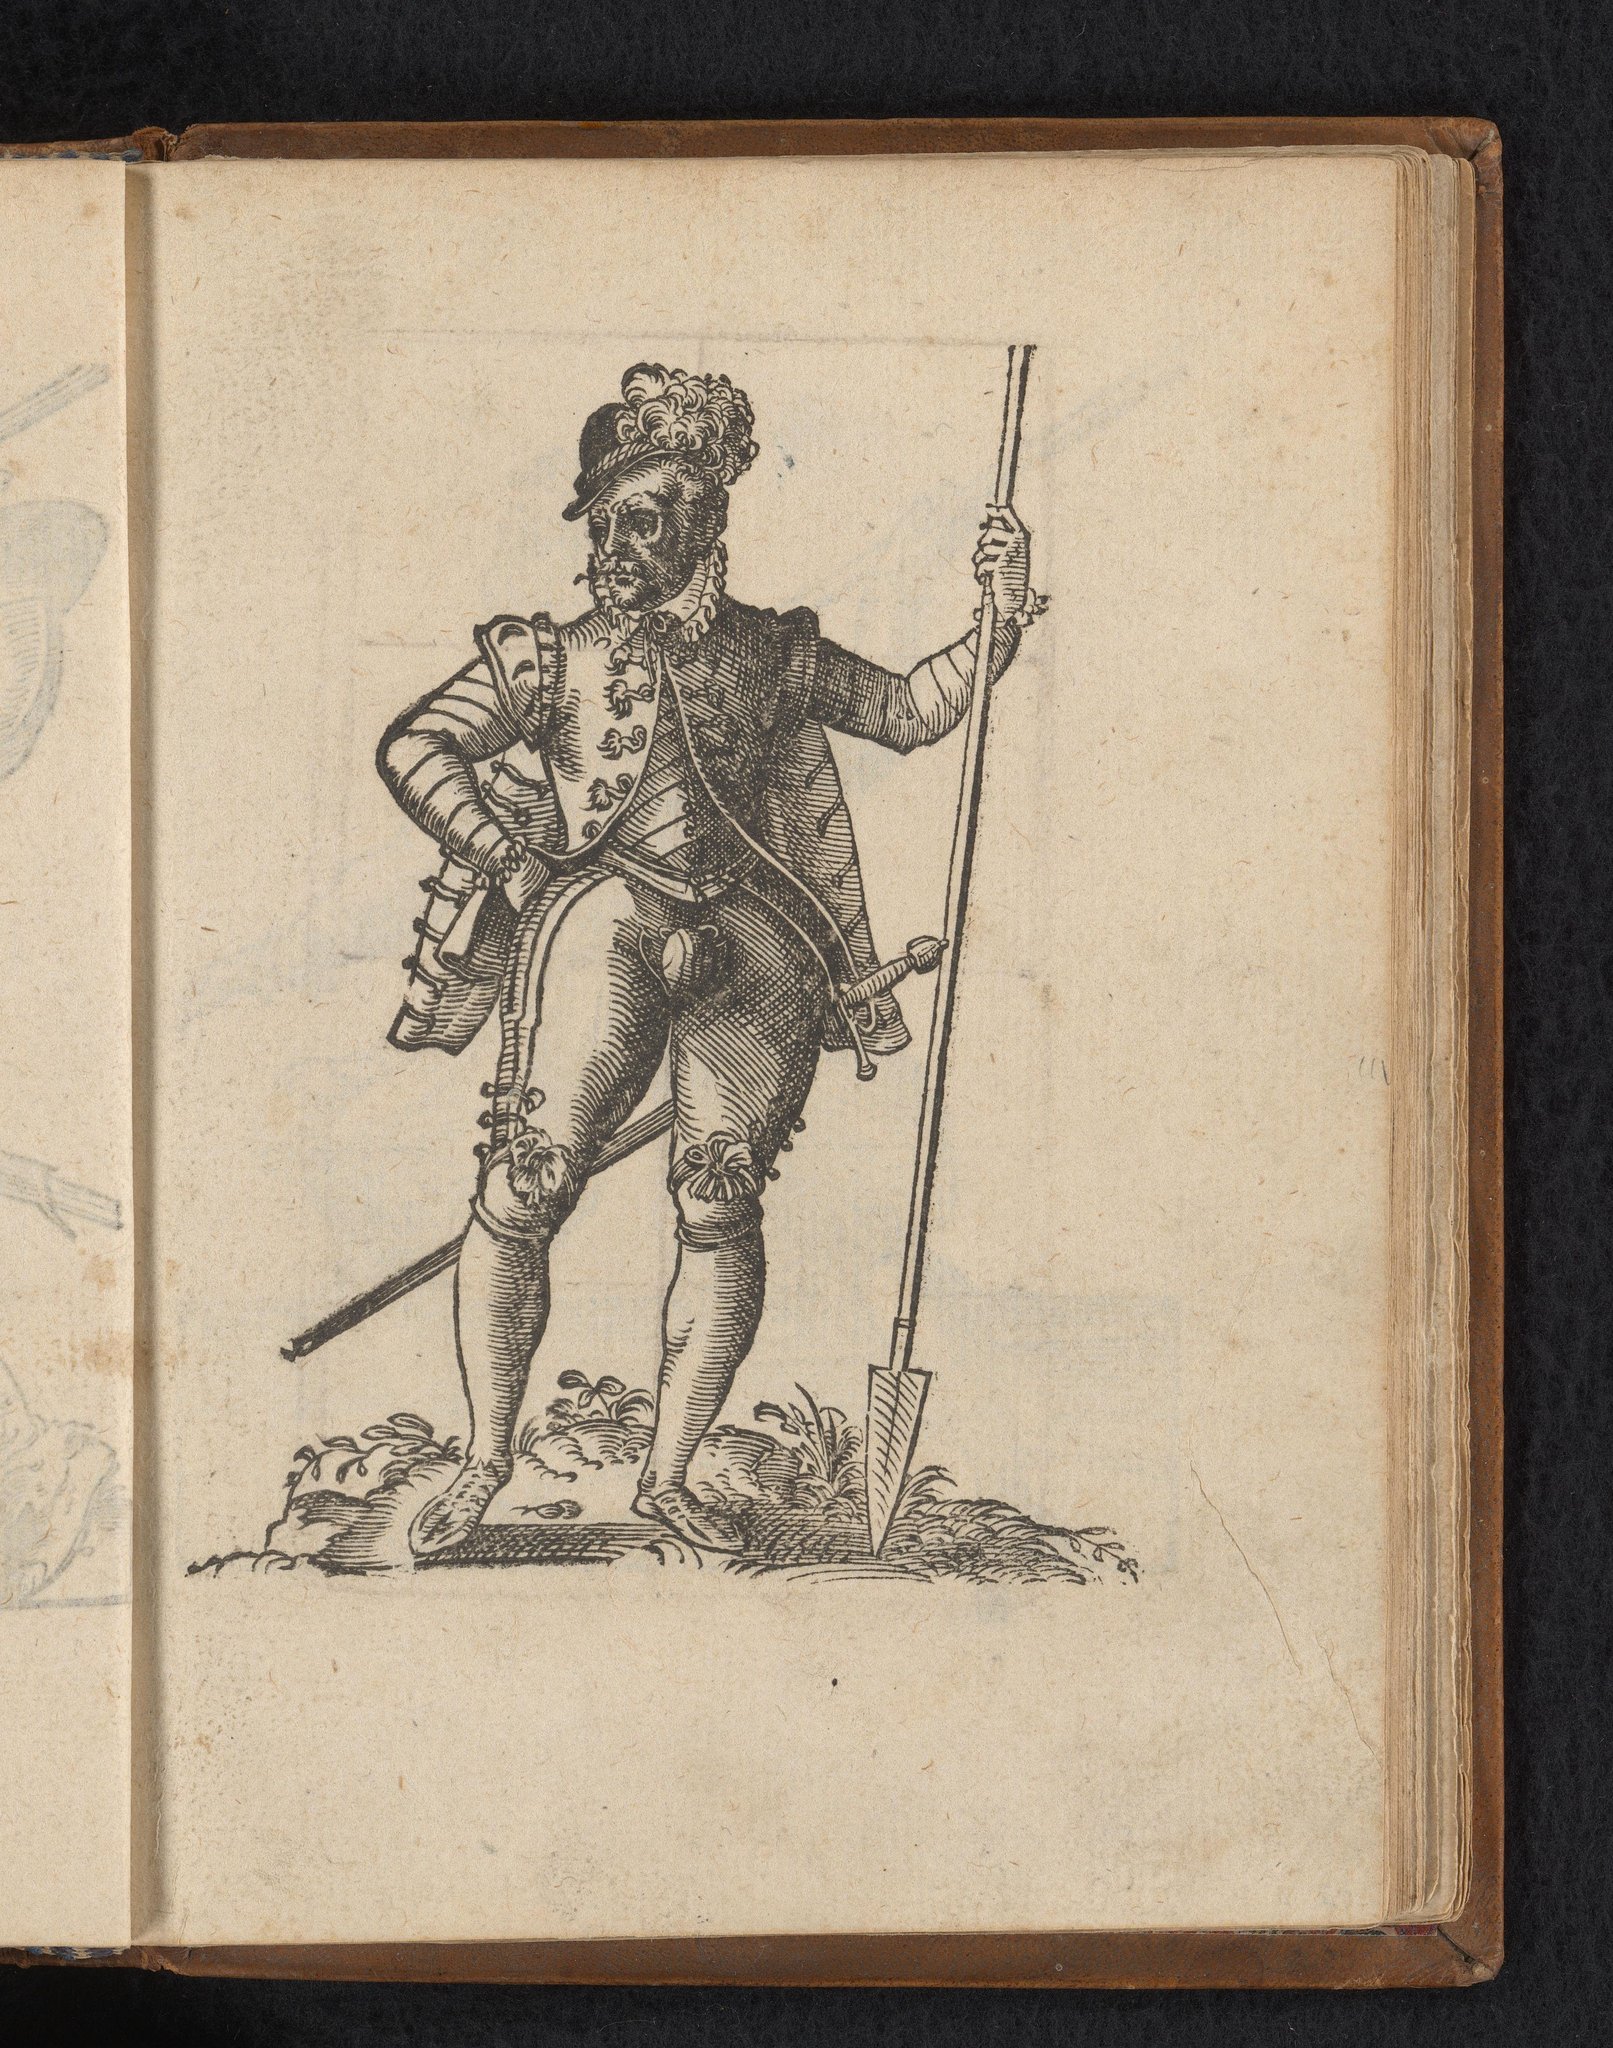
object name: print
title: Staande edelman met lans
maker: Anonymous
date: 1578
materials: paper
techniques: woodcut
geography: nuremberg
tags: nobility and patriciate; chivalry, knighthood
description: Staande edelman met een lans in de hand, met de punt op de grond. Onderdeel van het modelboek Enchiridion artis pingendi, fingendi & sculpendi met 108 figuren bedoeld voor beginnende schilders, beeldhouwers en prentmakers.